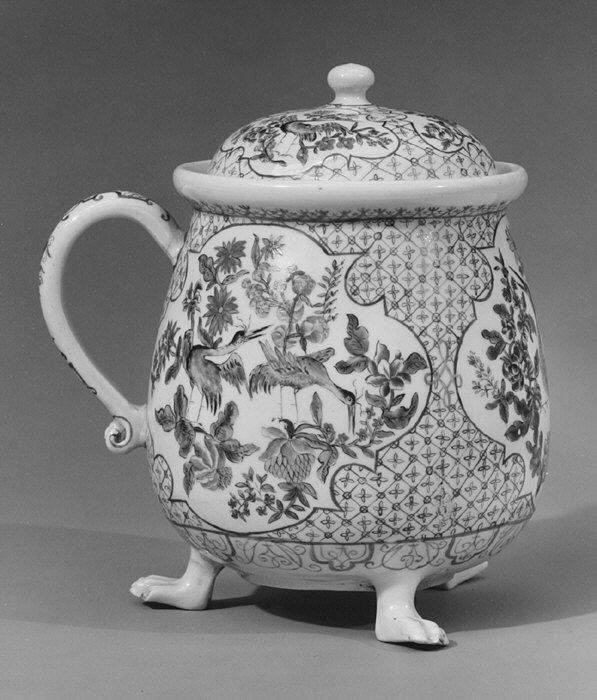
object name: sugar box with cover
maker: meissen manufactory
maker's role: manufactory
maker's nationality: german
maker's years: 1710-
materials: hard paste porcelain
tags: birds,flowers,leaves